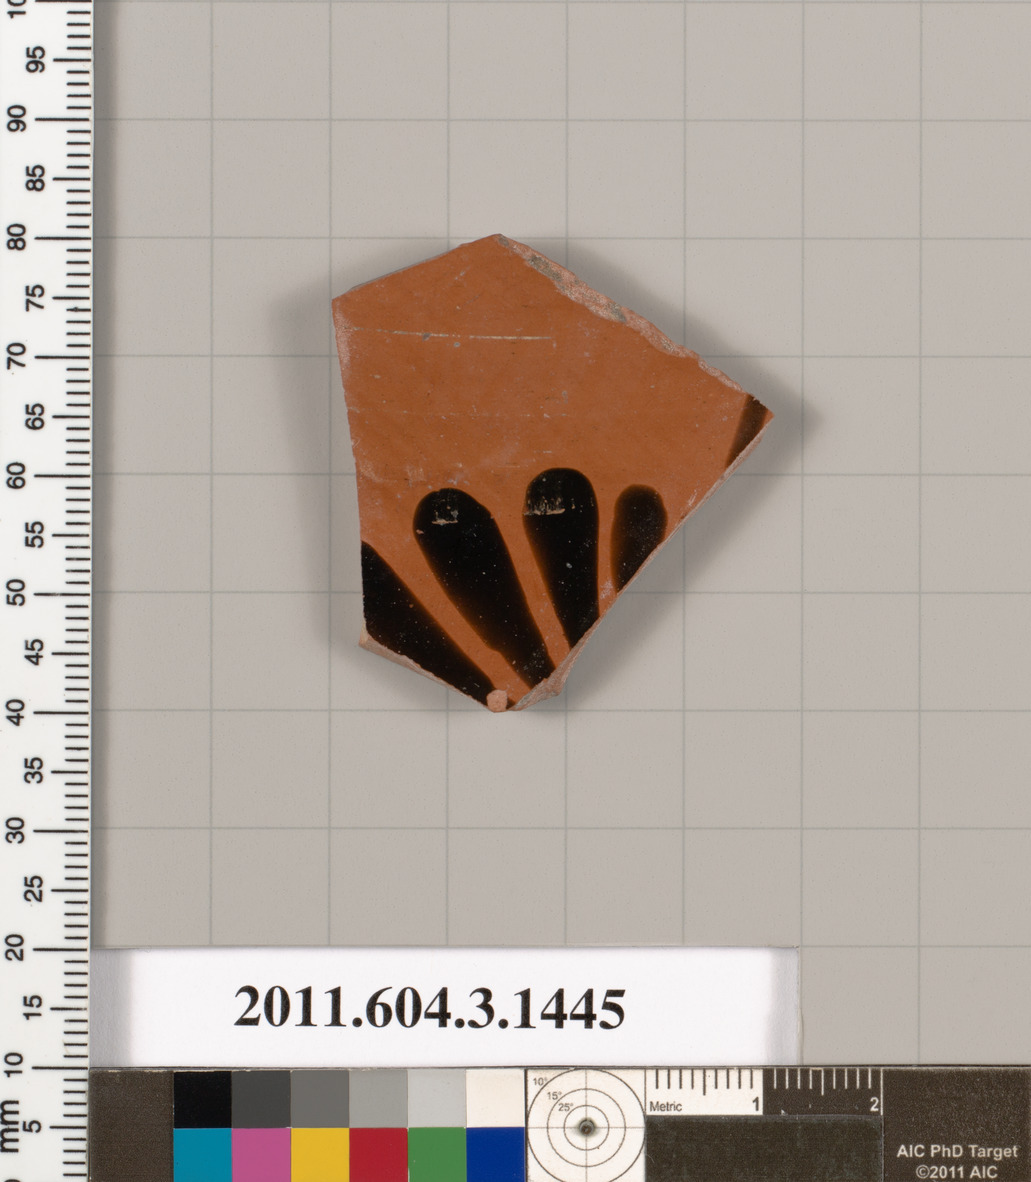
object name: skyphos fragment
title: Terracotta fragment of a skyphos (deep drinking cup)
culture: greek, attic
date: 534-468 BCE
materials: terracotta